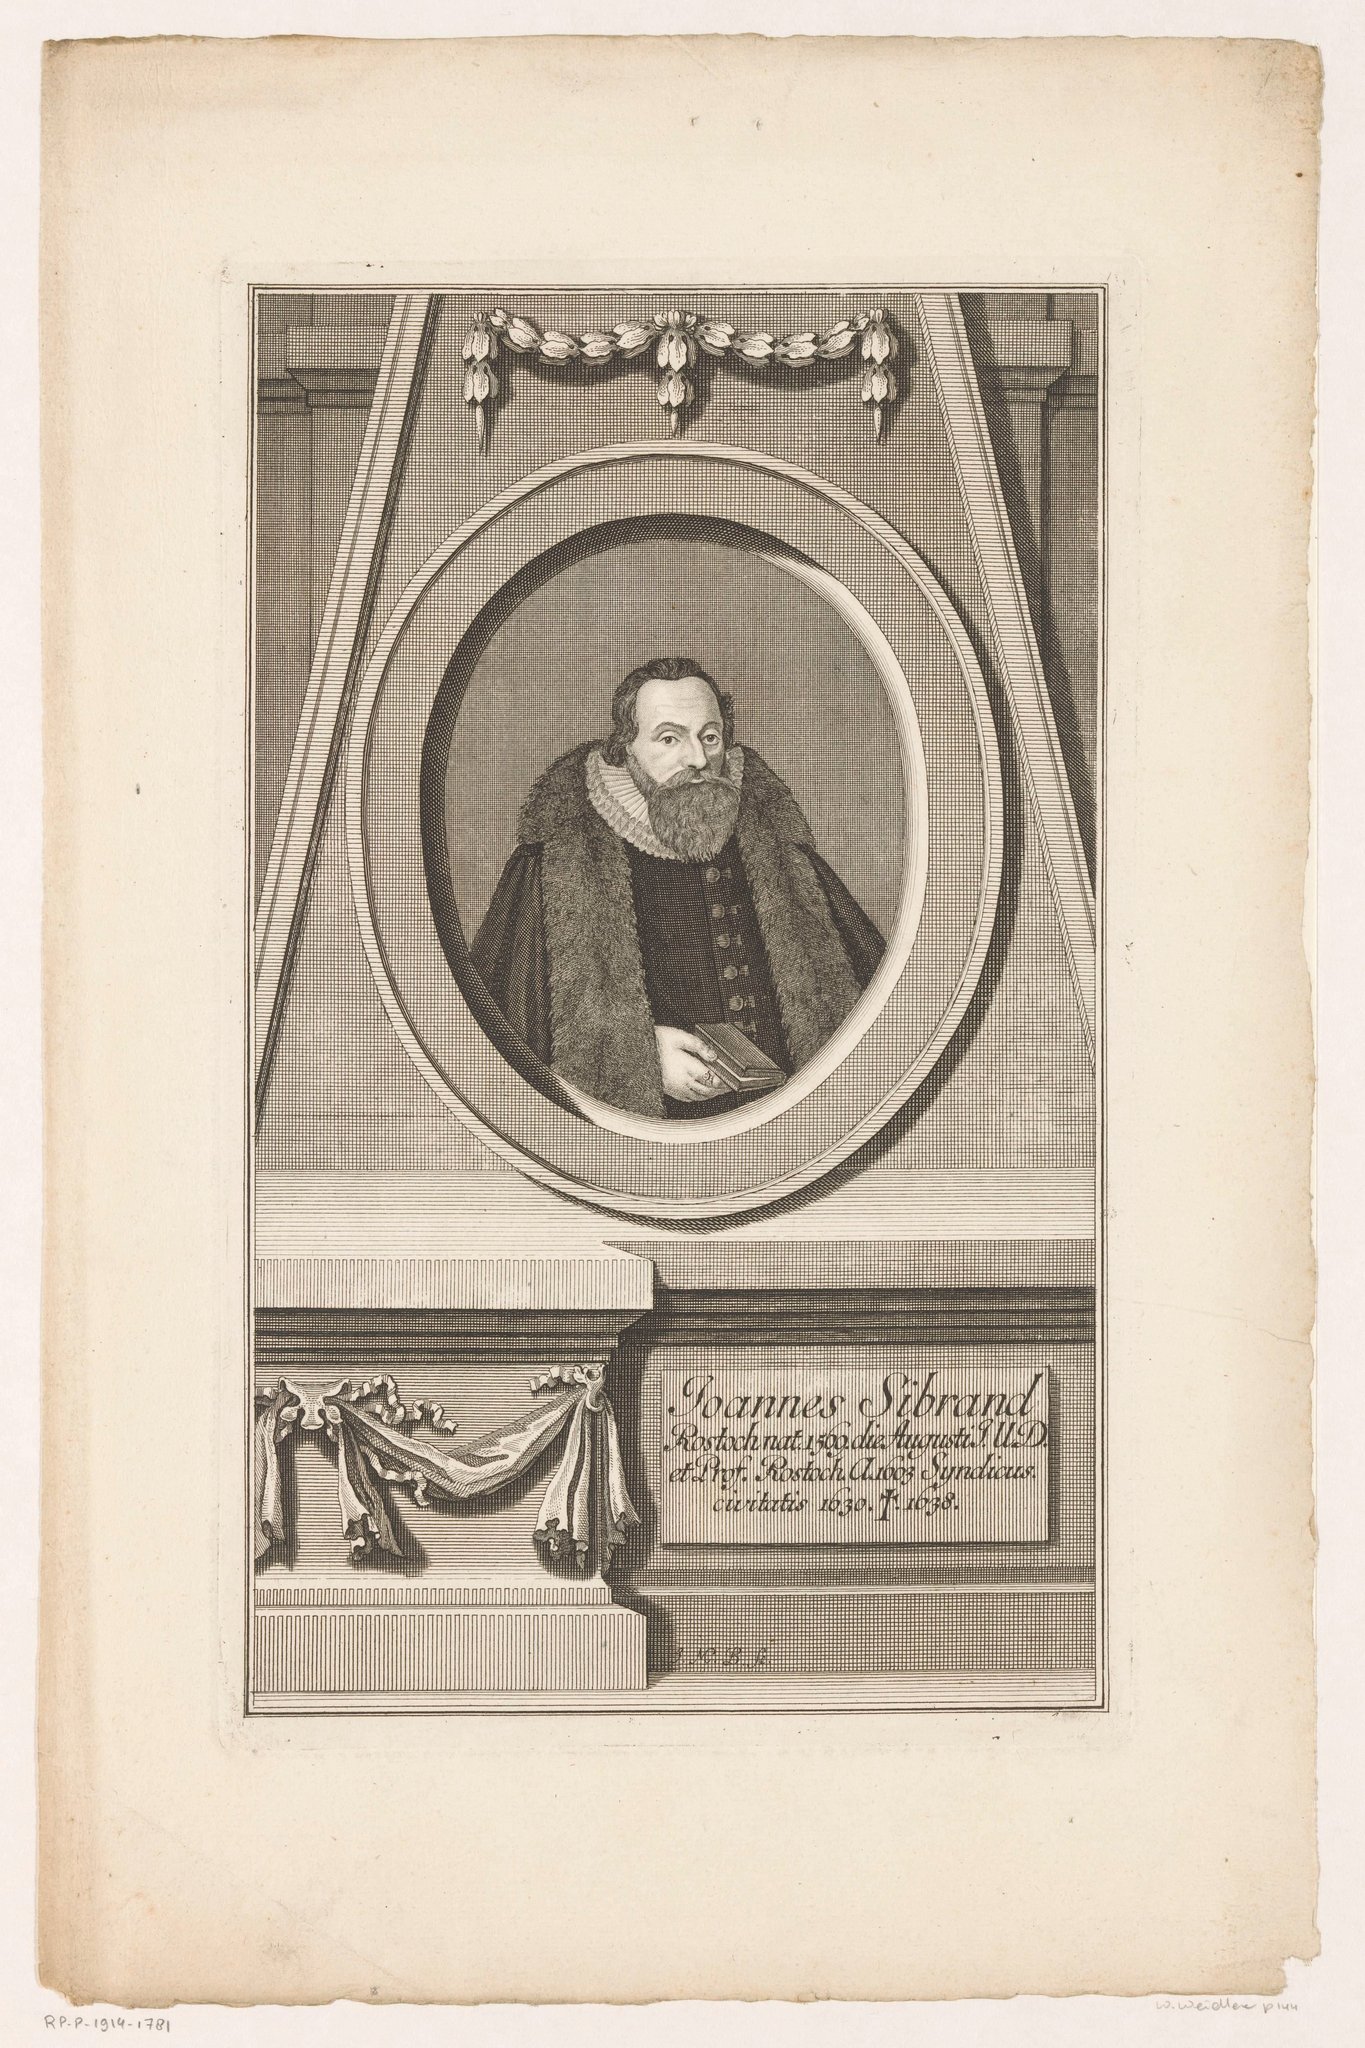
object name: print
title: Portret van Johann Sibrand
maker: johann martin bernigeroth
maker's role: print maker, publisher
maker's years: 1713-1767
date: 1743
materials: paper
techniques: engraving, etching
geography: leipzig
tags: historical persons, book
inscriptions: collector's mark: Lugt 2228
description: Een andere staat van deze prent is gebruikt in: Westphalen, Ernst Joachim von. Monumenta Inedita Rerum Germanicarum Praecipue Cimbricarum Et Megapolensium (...). 4 dln. Leipzig: Johann Christian Martini, 1739-1745, dl. 3 (1743), na p. 1379.